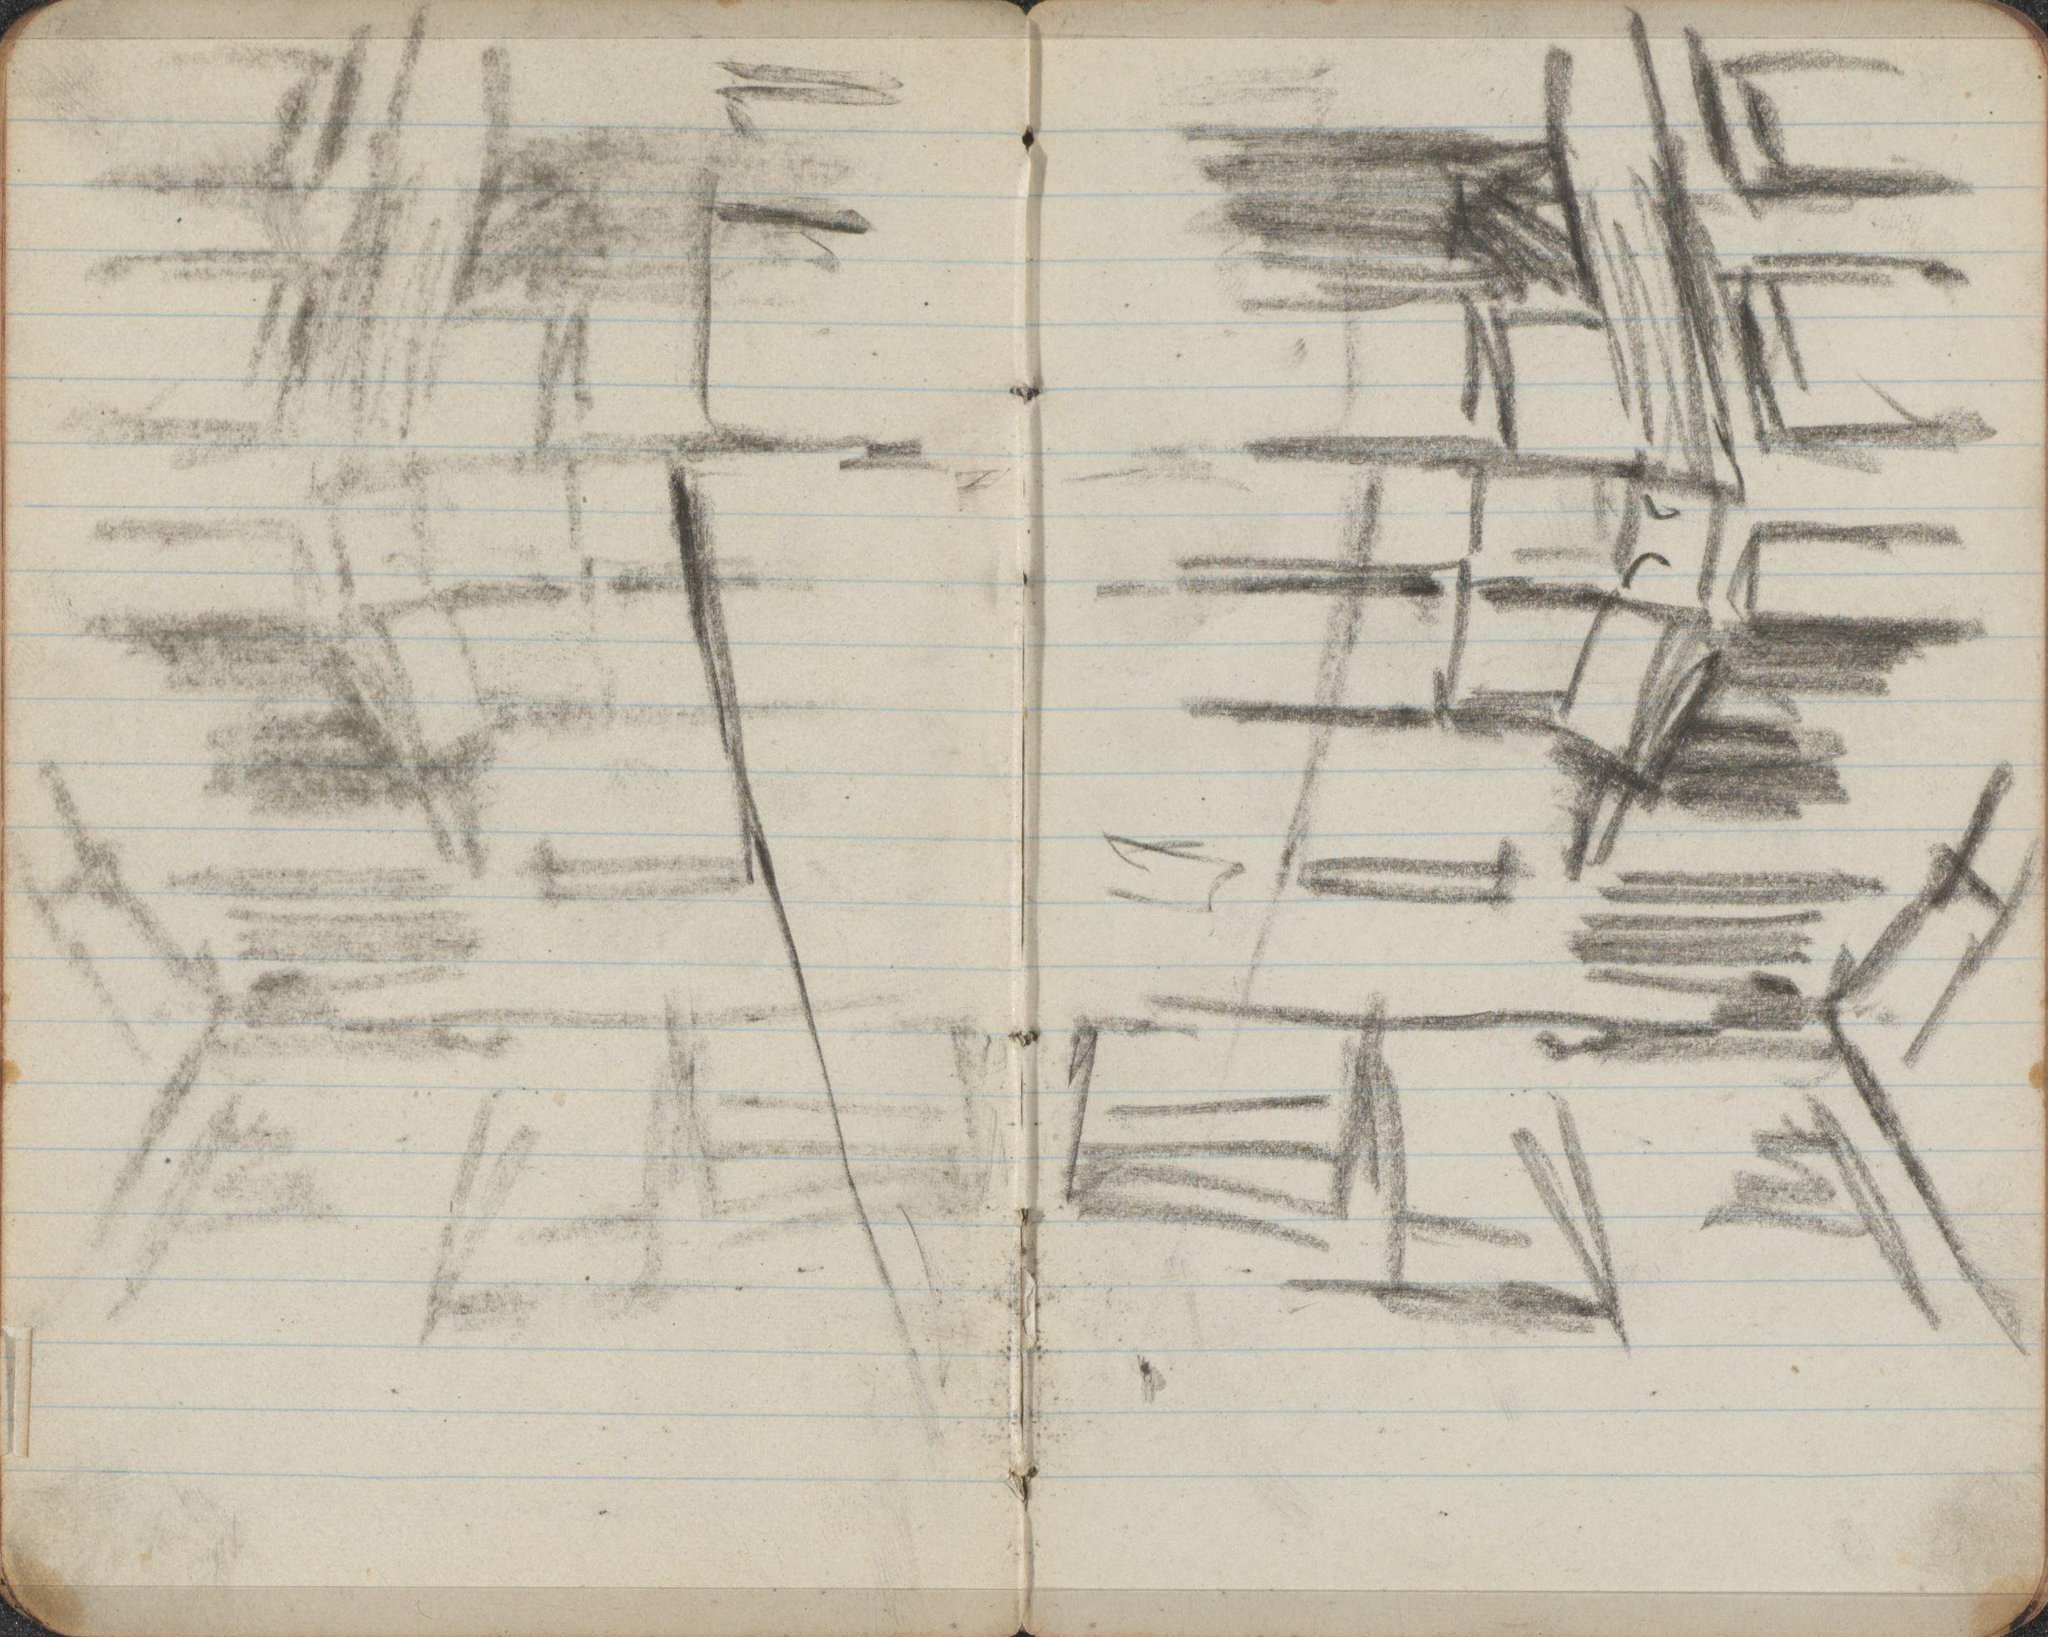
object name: sketchbook leaf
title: Gevel van een winkel op de Nieuwendijk te Amsterdam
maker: george hendrik breitner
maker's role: draughtsman, painter, print maker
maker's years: 1857-1923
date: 1894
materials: chalk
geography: amsterdam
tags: shop, store, façade (of house or building), street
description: Pagina 17 en pagina 18 uit een schetsboek met 31 bladen.